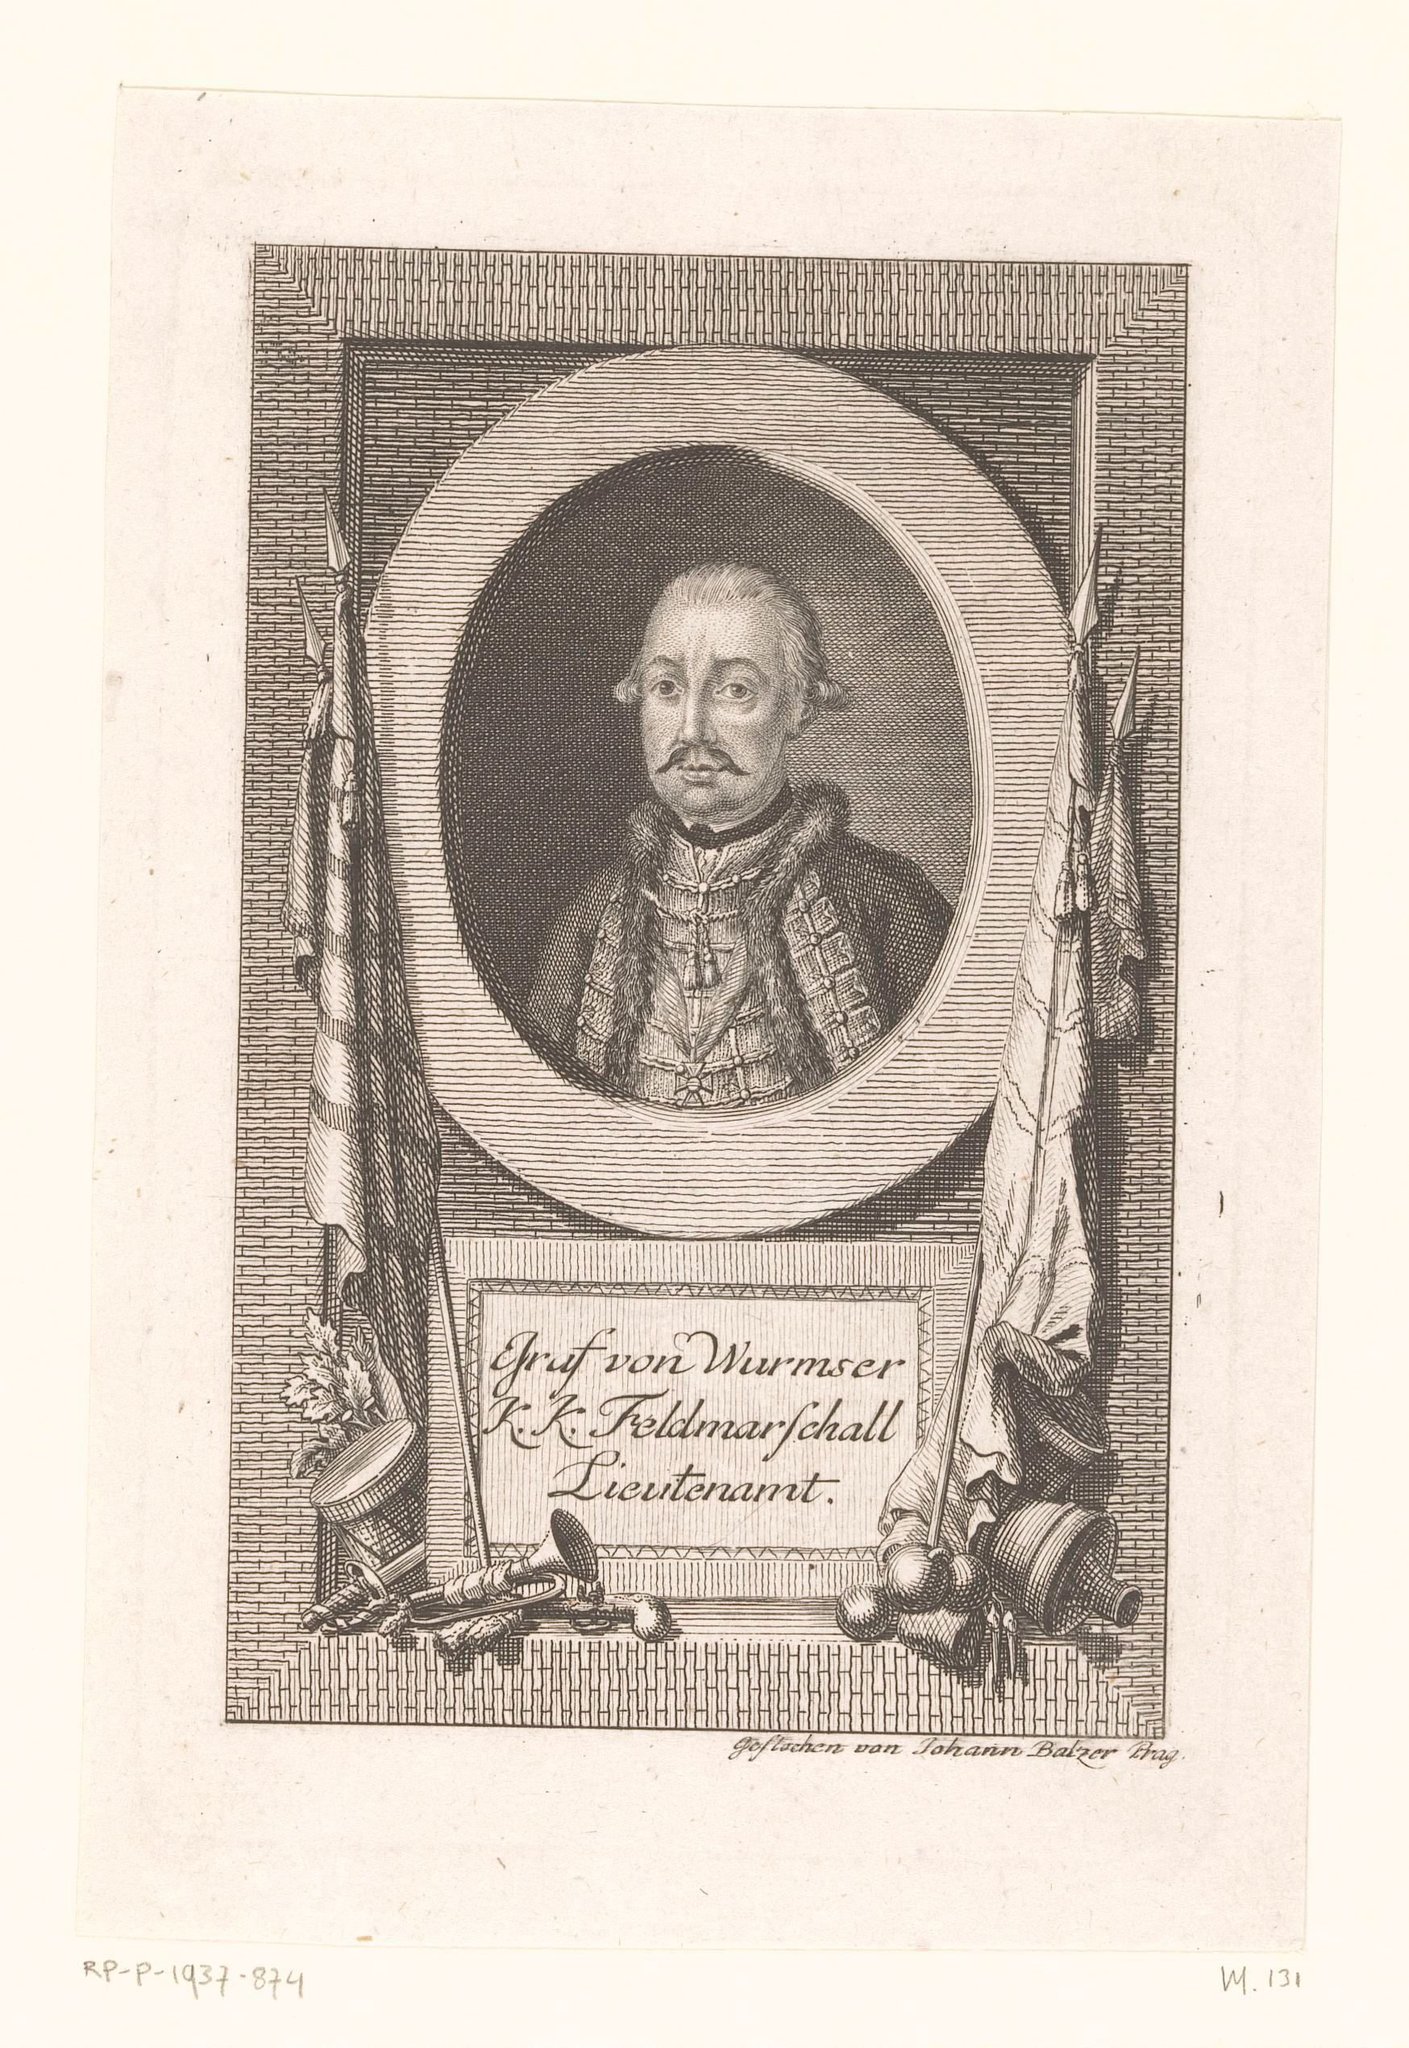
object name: print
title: Graf von Wurmser K.K. Feldmarschall Lieutenant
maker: jan balzer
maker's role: print maker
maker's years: 1736-1799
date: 1746-1799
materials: paper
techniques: engraving, etching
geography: prague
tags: historical persons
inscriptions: collector's mark: Lugt 2228